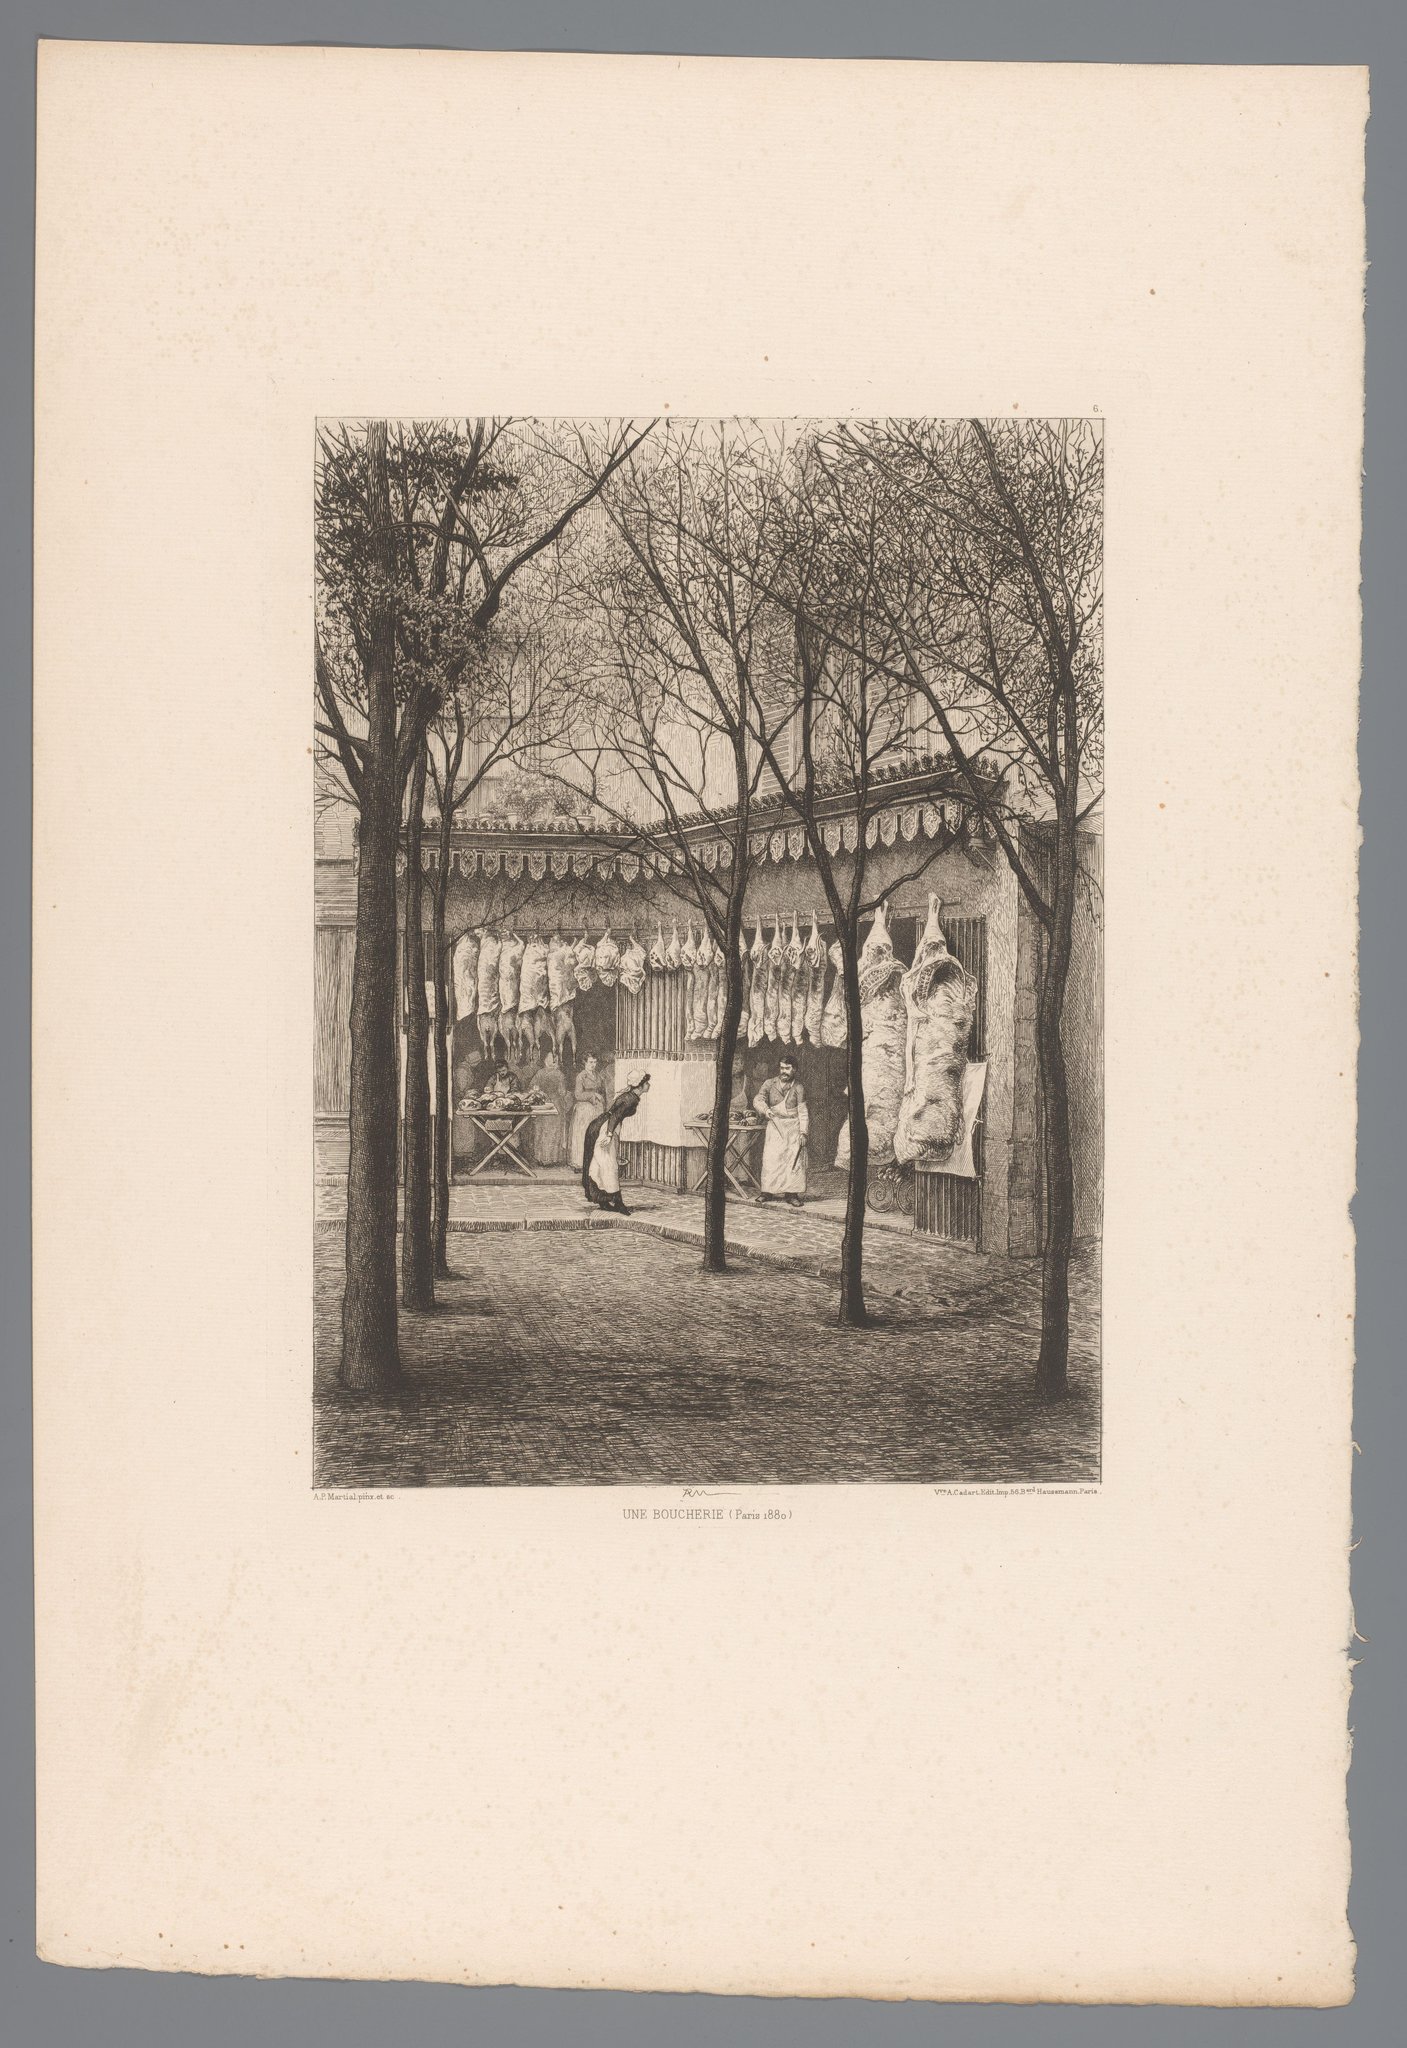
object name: print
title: Franse etsen uit 1881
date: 1881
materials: paper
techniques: drypoint, etching, intaglio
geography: paris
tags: slaughtered ox or pig, butcher, slaughterman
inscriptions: collector's mark: ‘AFE v S’, collector's mark: Lugt 2760, collector's mark: Lugt 2228